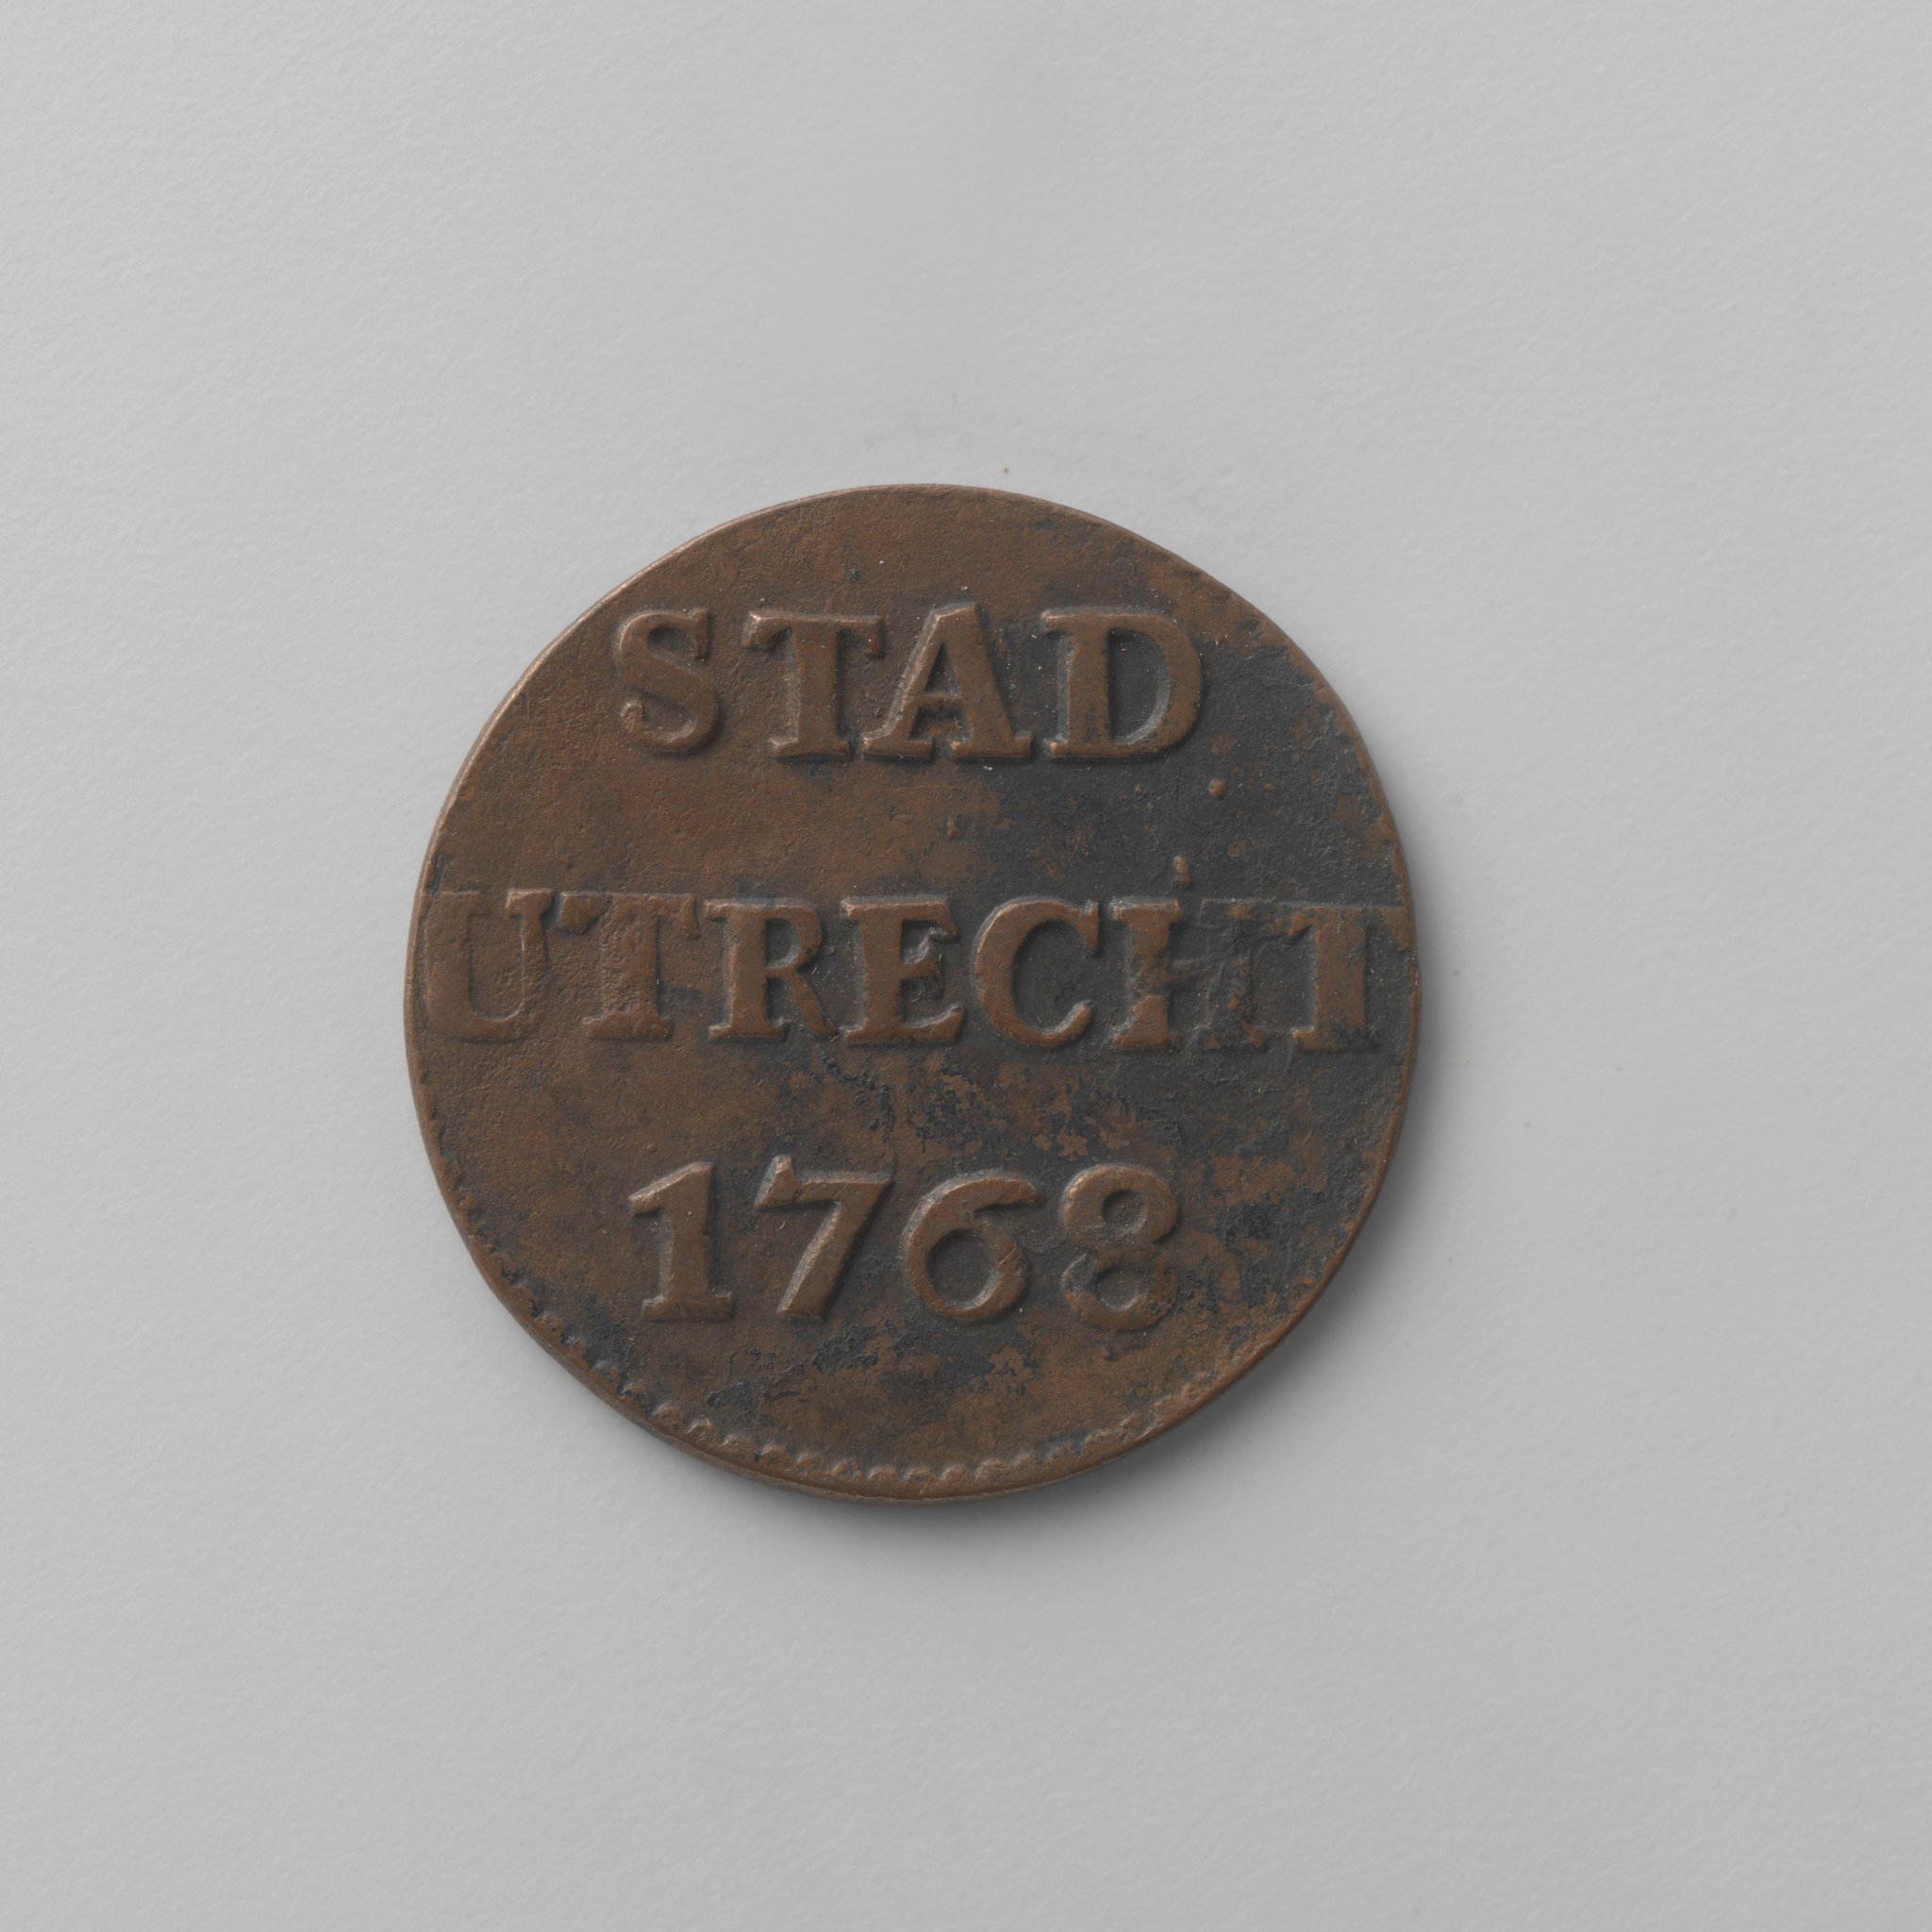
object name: coin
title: Stad Utrecht, duit, 1768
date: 1768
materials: copper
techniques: striking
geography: utrecht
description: Koperen munt. Voorzijde: gekroond stedelijk wapenschild, gehouden door twee leeuwen met in afsnede dikke lijn, waaronder een versierde accolade met een grote schelp. Keerzijde: opschrift in twee regels, waaronder jaartal. Jaartal met Arabische 1.